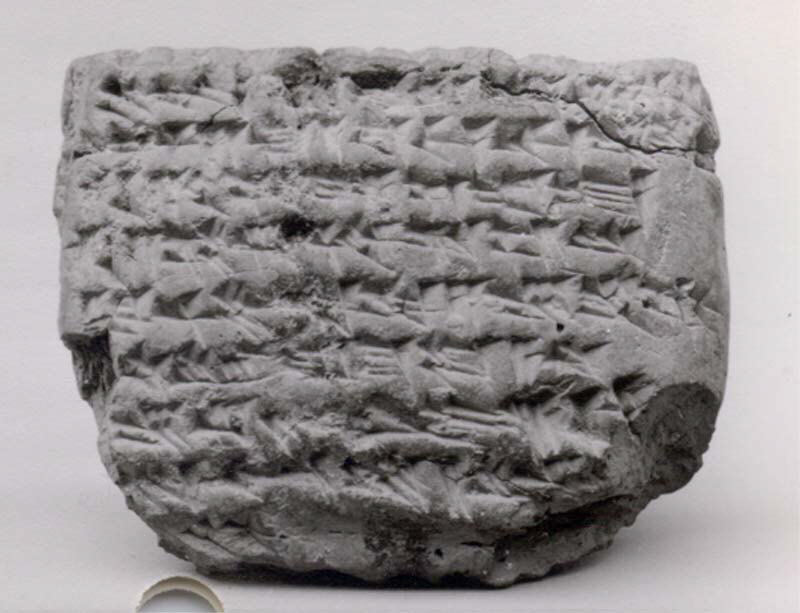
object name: cuneiform tablet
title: Cuneiform tablet: lease renewal, archive of Bel-remanni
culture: achaemenid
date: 487 BCE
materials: clay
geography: mesopotamia